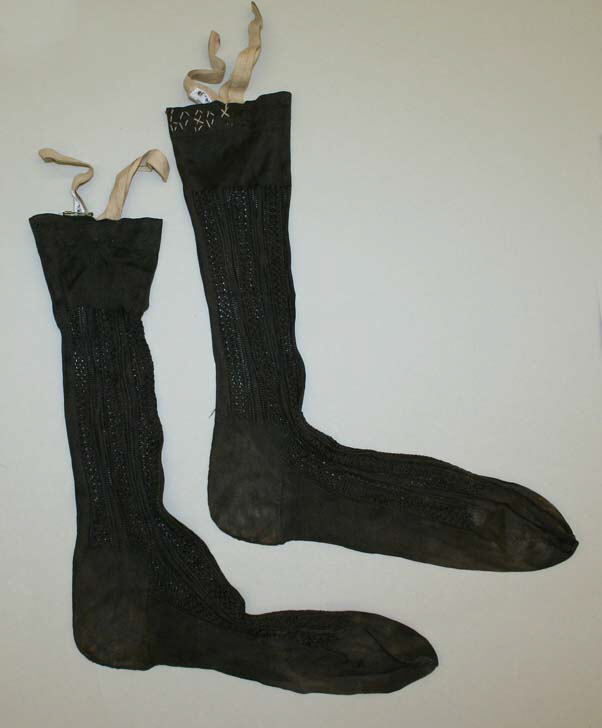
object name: sock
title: Socks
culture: american or european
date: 1830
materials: silk